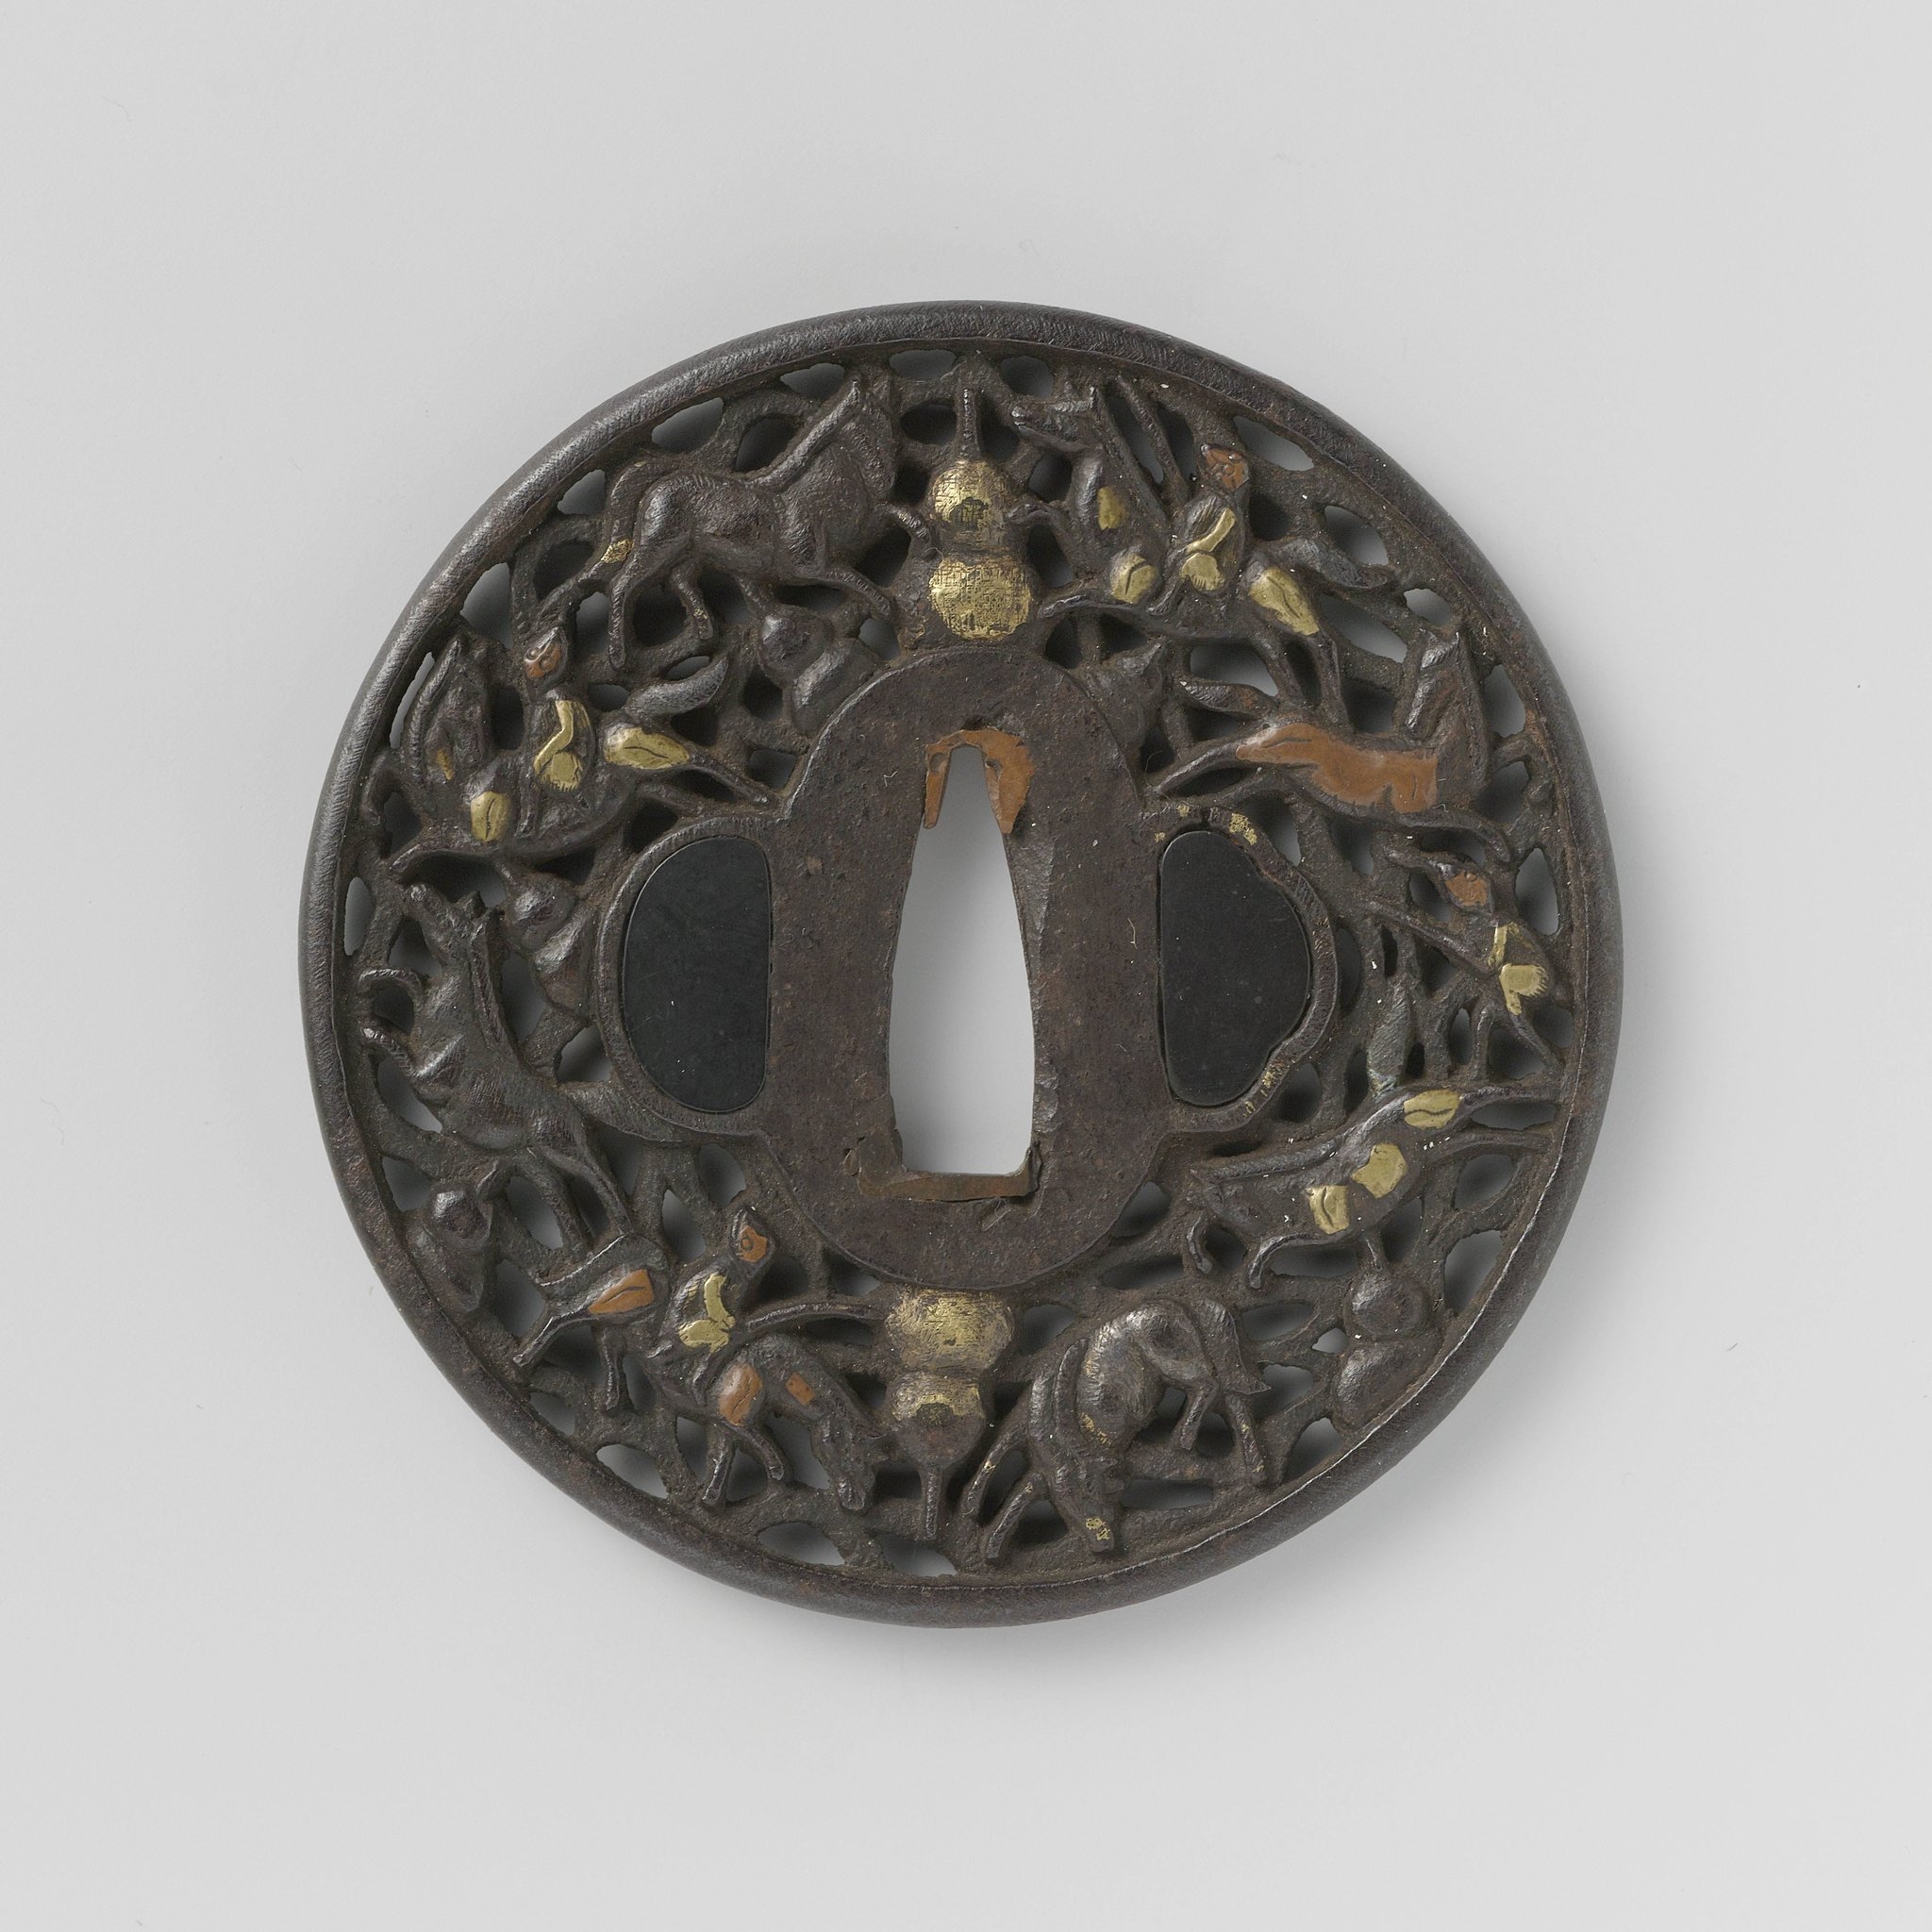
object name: tsuba, zwaardstootplaat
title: Hand guard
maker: Anonymous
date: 1600-1900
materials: copper, gold, iron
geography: japan